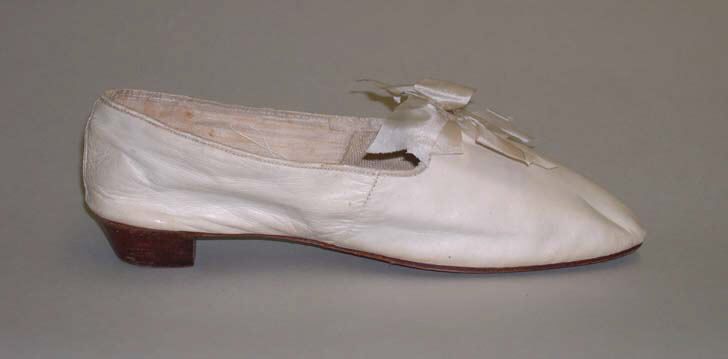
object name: wedding slipper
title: Wedding slippers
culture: american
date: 1819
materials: leather, silk